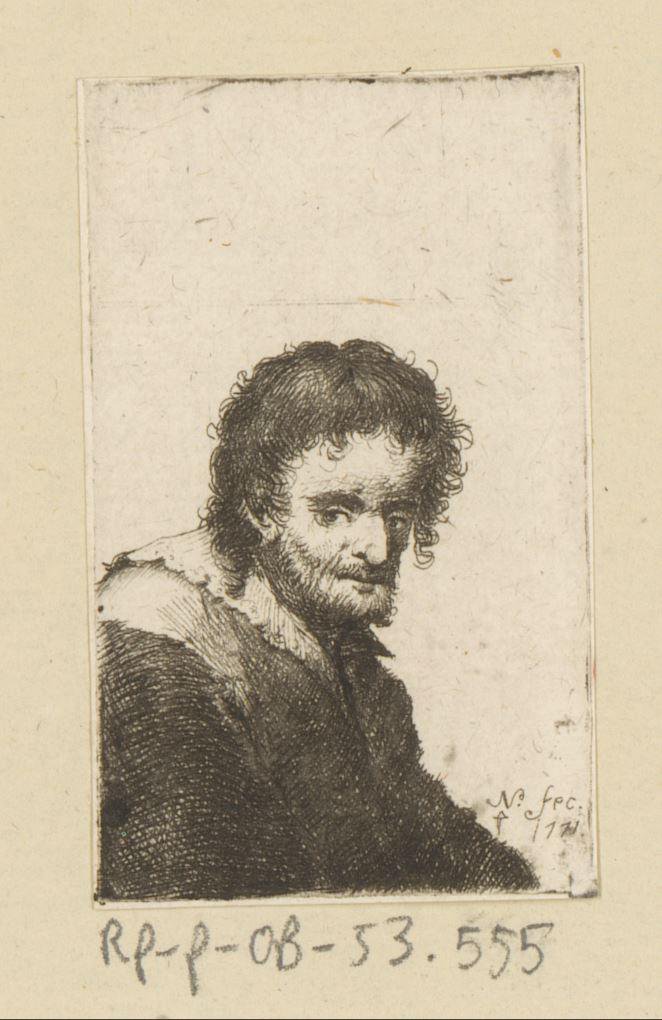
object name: print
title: Boerenman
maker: johann andreas benjamin nothnagel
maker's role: print maker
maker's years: 1729-1804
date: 1771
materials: paper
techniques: drypoint, etching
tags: adult man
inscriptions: collector's mark: Lugt 240